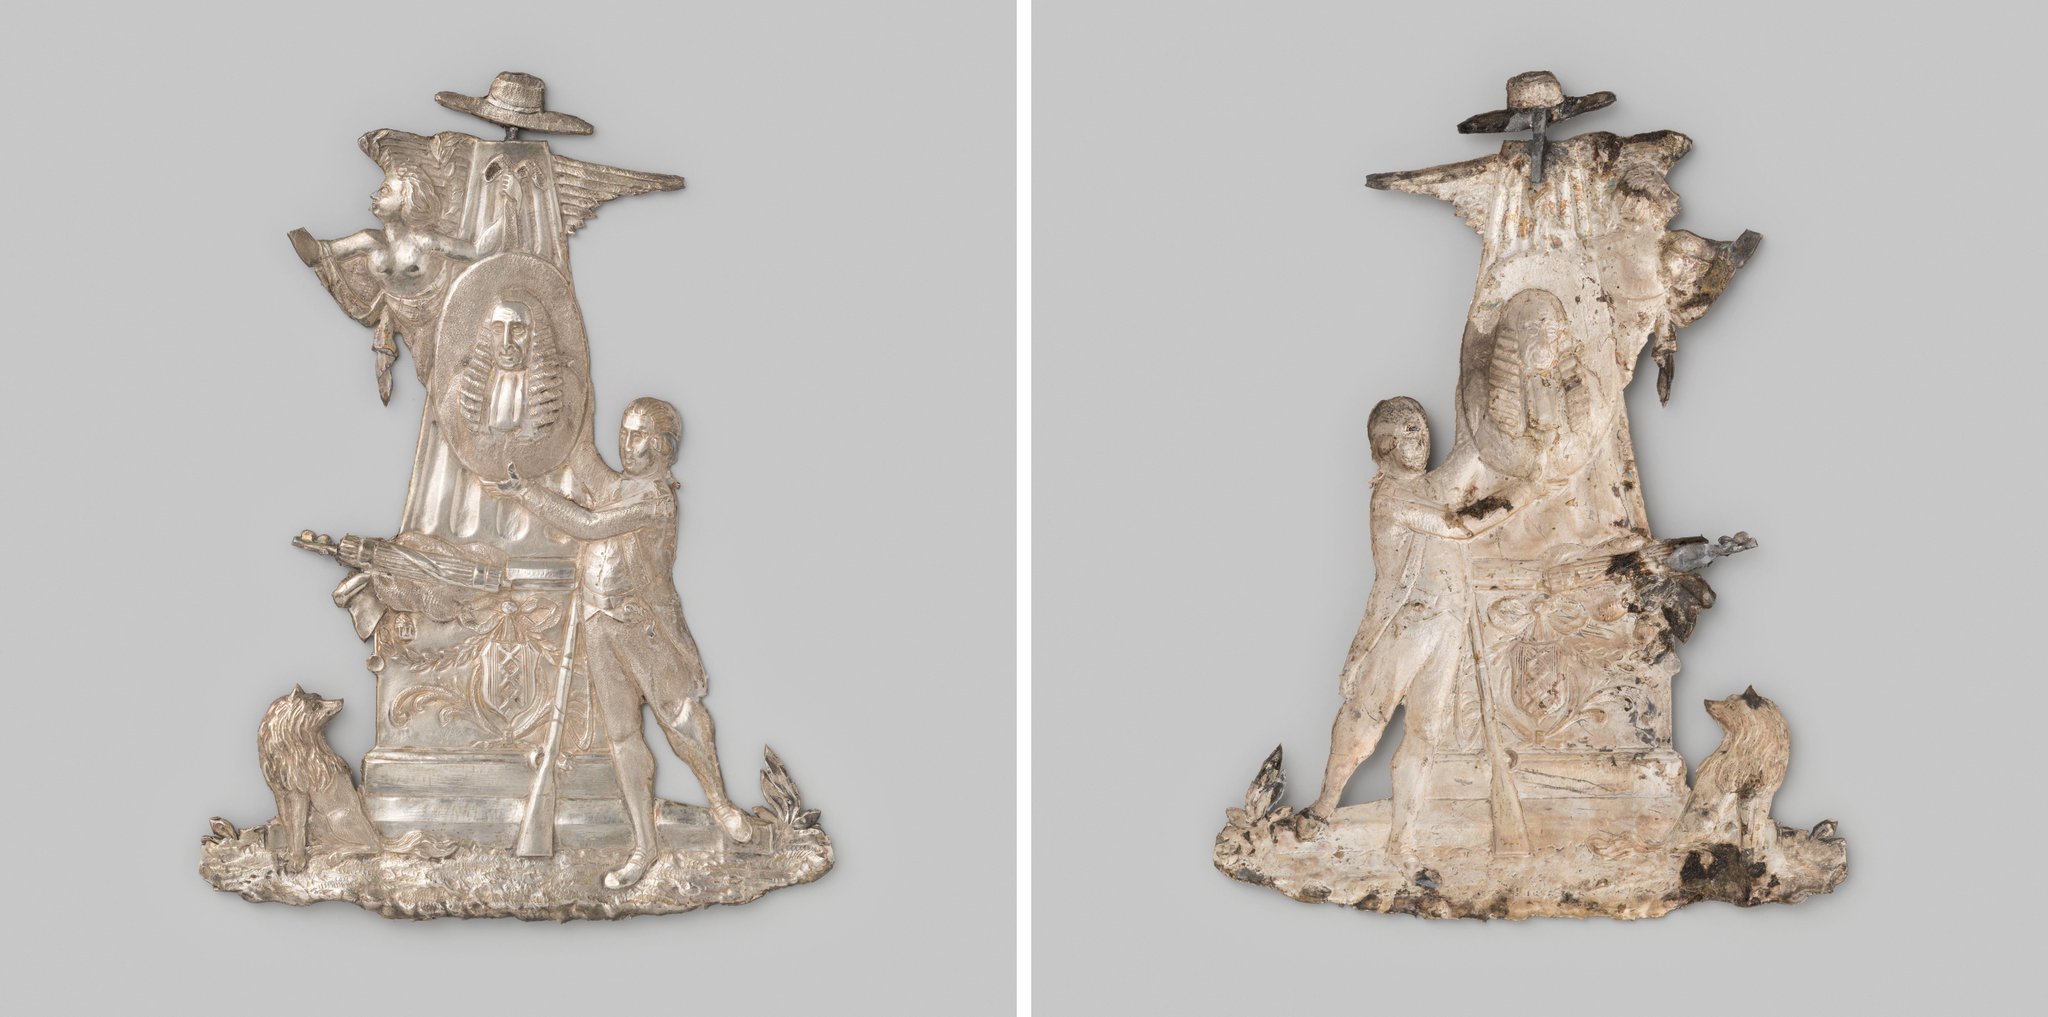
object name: plaque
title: Hendrik Danielsz Hooft, burgemeester van Amsterdam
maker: Anonymous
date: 1787-1794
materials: silver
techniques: embroidery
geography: netherlands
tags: amsterdam, mayor, hendrik danielsz. hooft